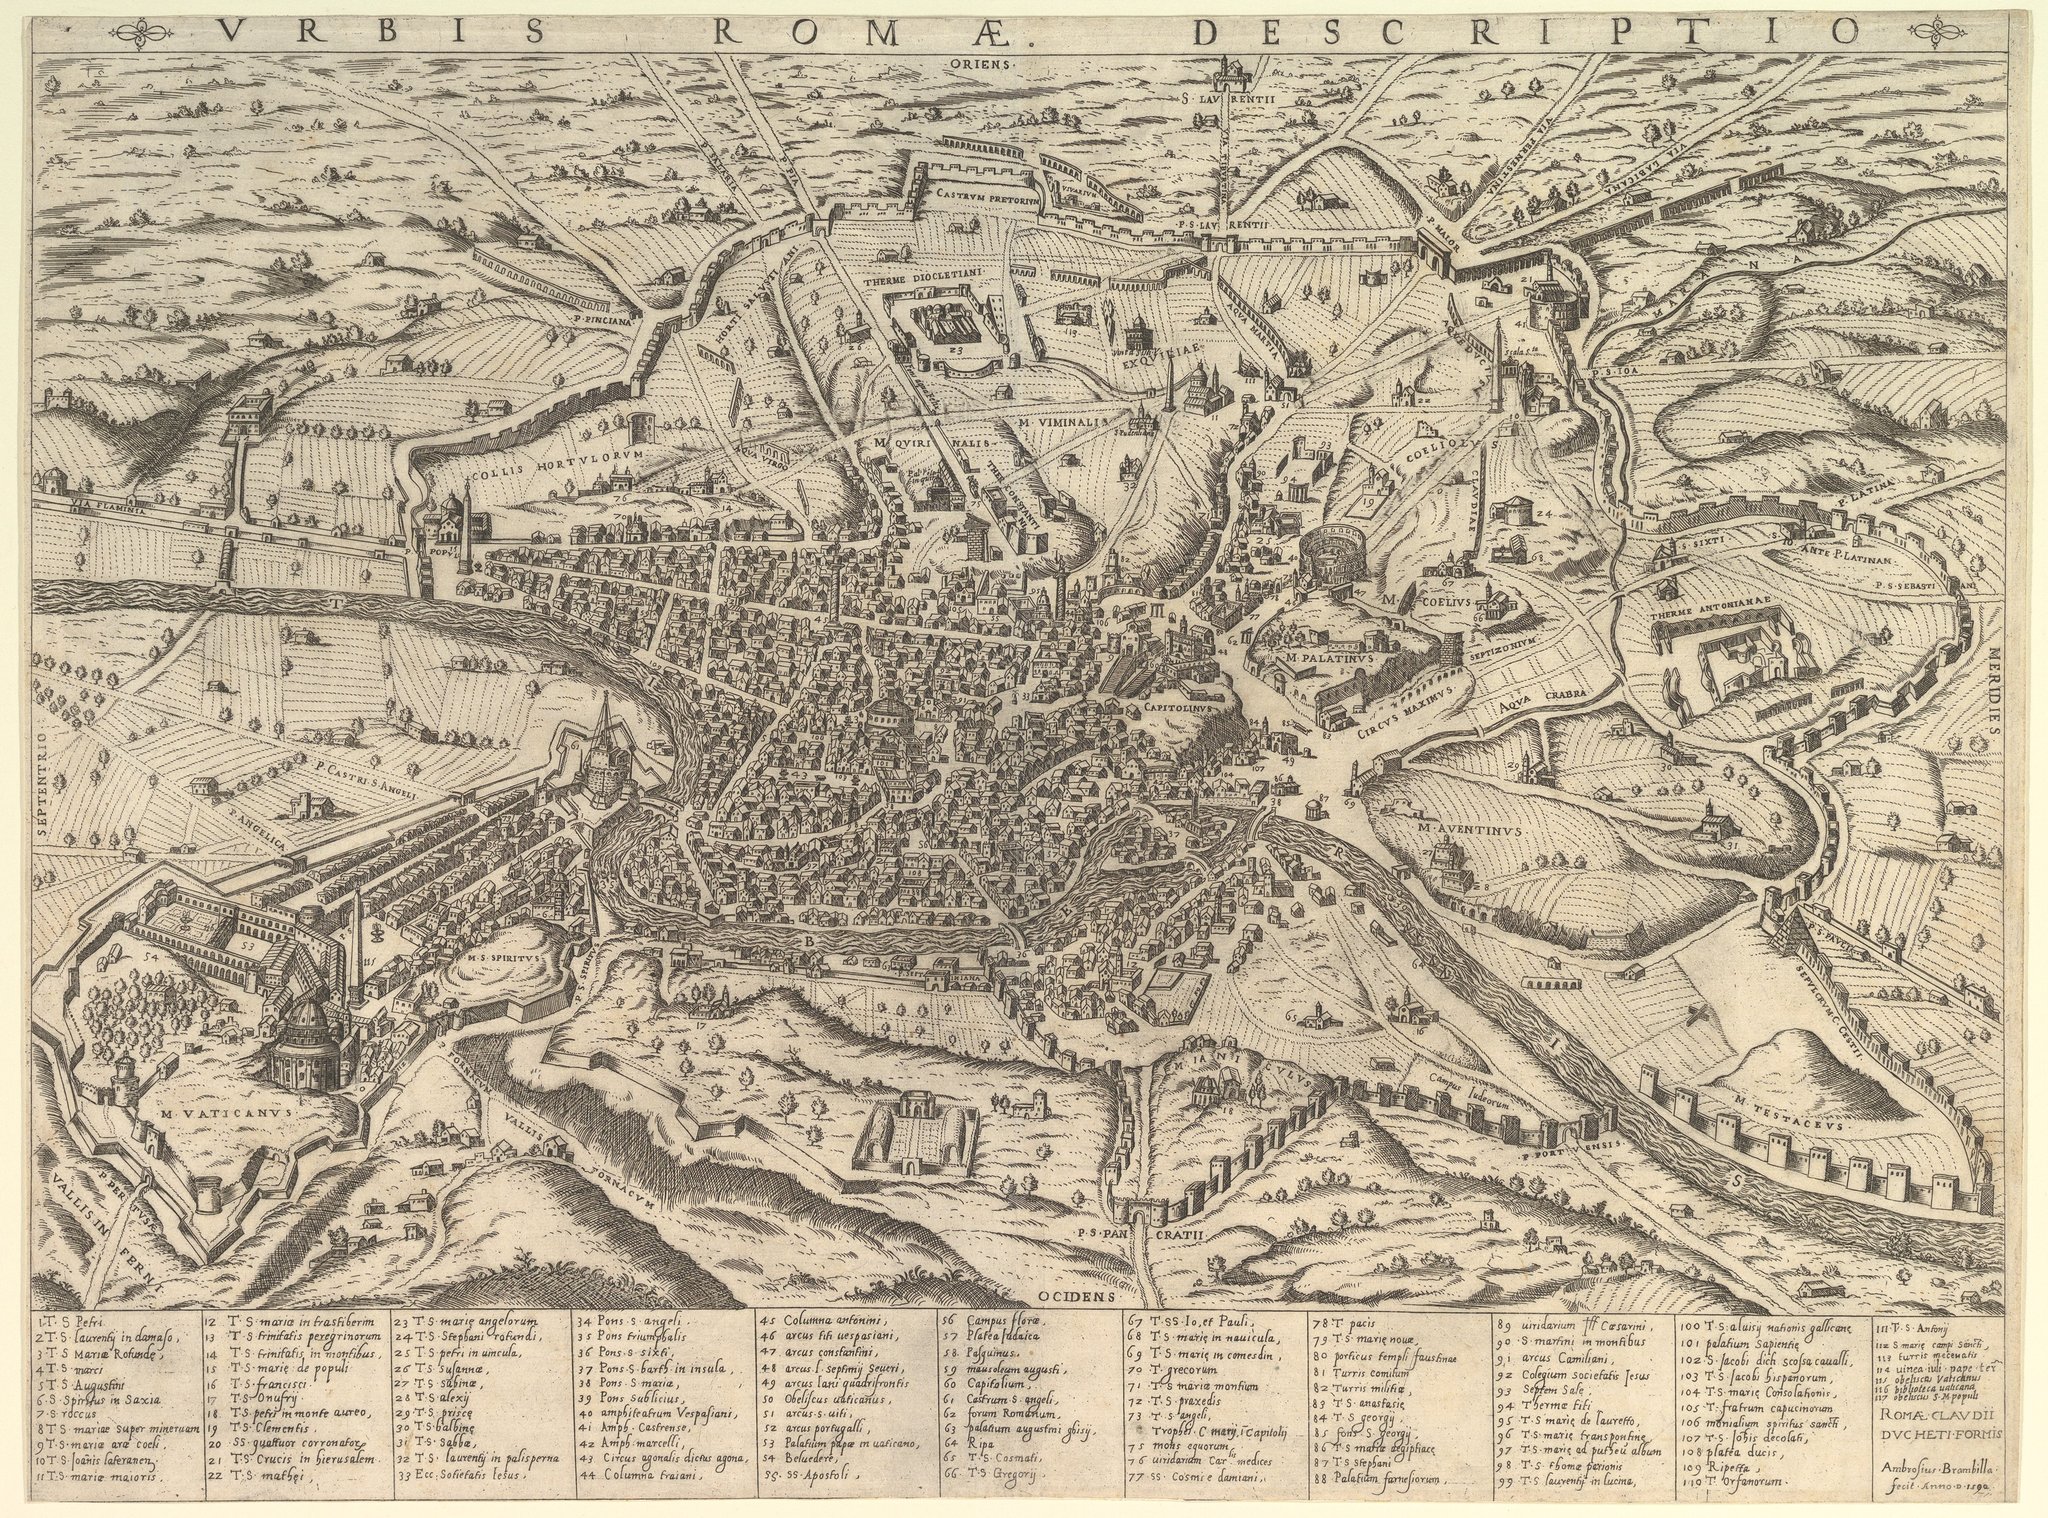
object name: print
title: View of Modern Rome from the West, from "Speculum Romanae Magnificentiae"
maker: giovanni ambrogio brambilla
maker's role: artist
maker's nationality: italian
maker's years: 1575-1599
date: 1590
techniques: etching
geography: rome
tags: maps,rome